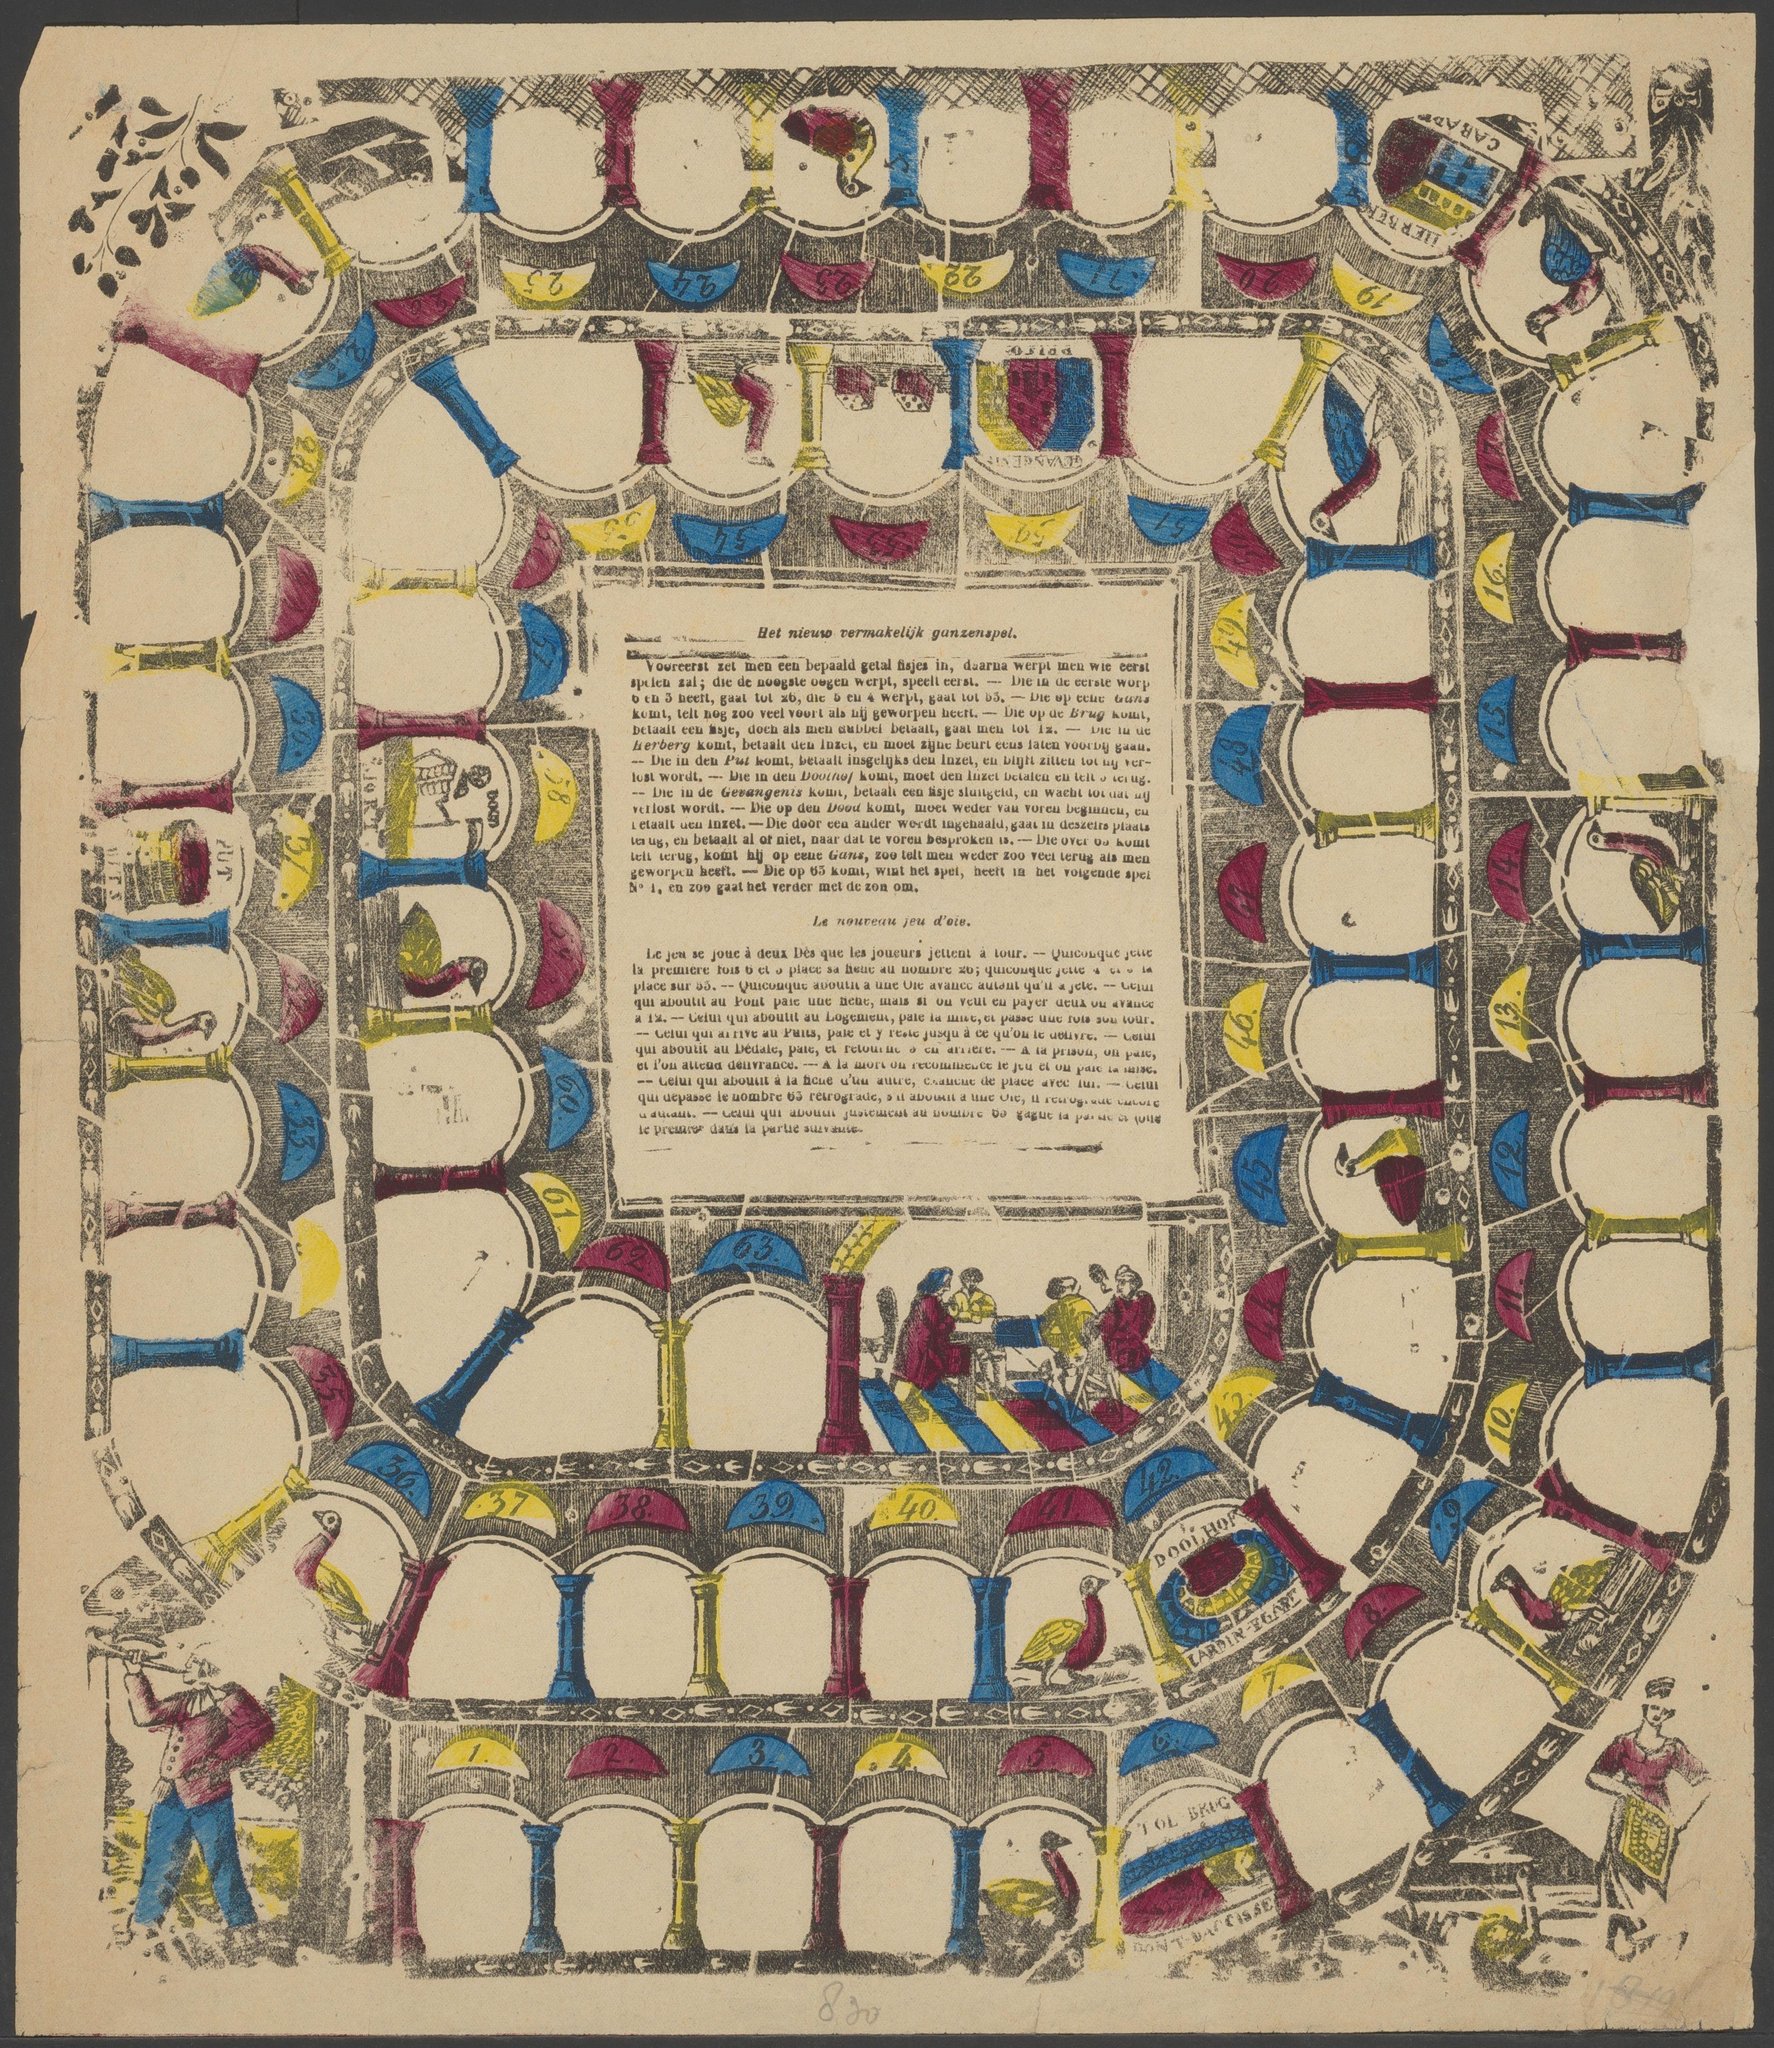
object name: popular print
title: Ganzenbordspel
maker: Anonymous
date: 1833-1856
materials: paper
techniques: hand coloring, letterpress printing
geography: turnhout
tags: goose-game, board-games of chance, board-games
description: Ganzenbordspel met een spiraal met vakken genummerd van 1 tot en met 63. In enkele vakken voorstellingen van ganzen. Op het middenveld de spelregels in boekdruk in het Nederlands en in het Frans. Onderwerpsrubrieken binnen de Atlas Zeden en Gewoonten: Zeden en gewoonten in engeren zin, Spel en vermaak, Gezelschapsspel II, Ganzenbord en dergelijke.